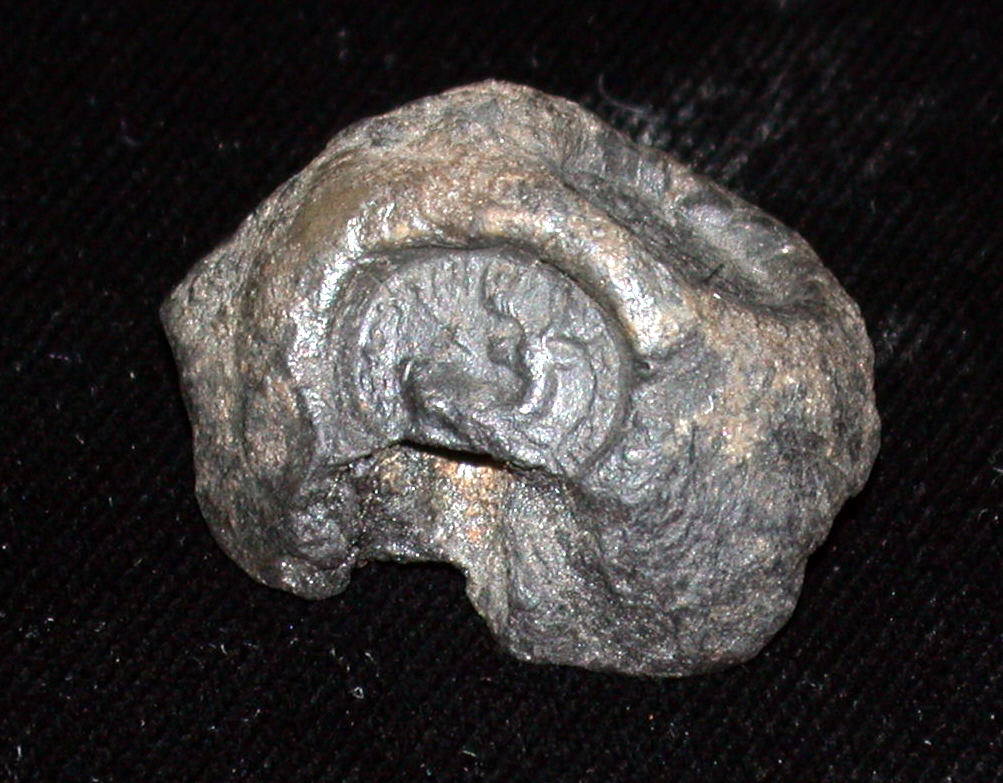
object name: sealing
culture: sasanian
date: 601-700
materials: clay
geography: iran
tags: animals